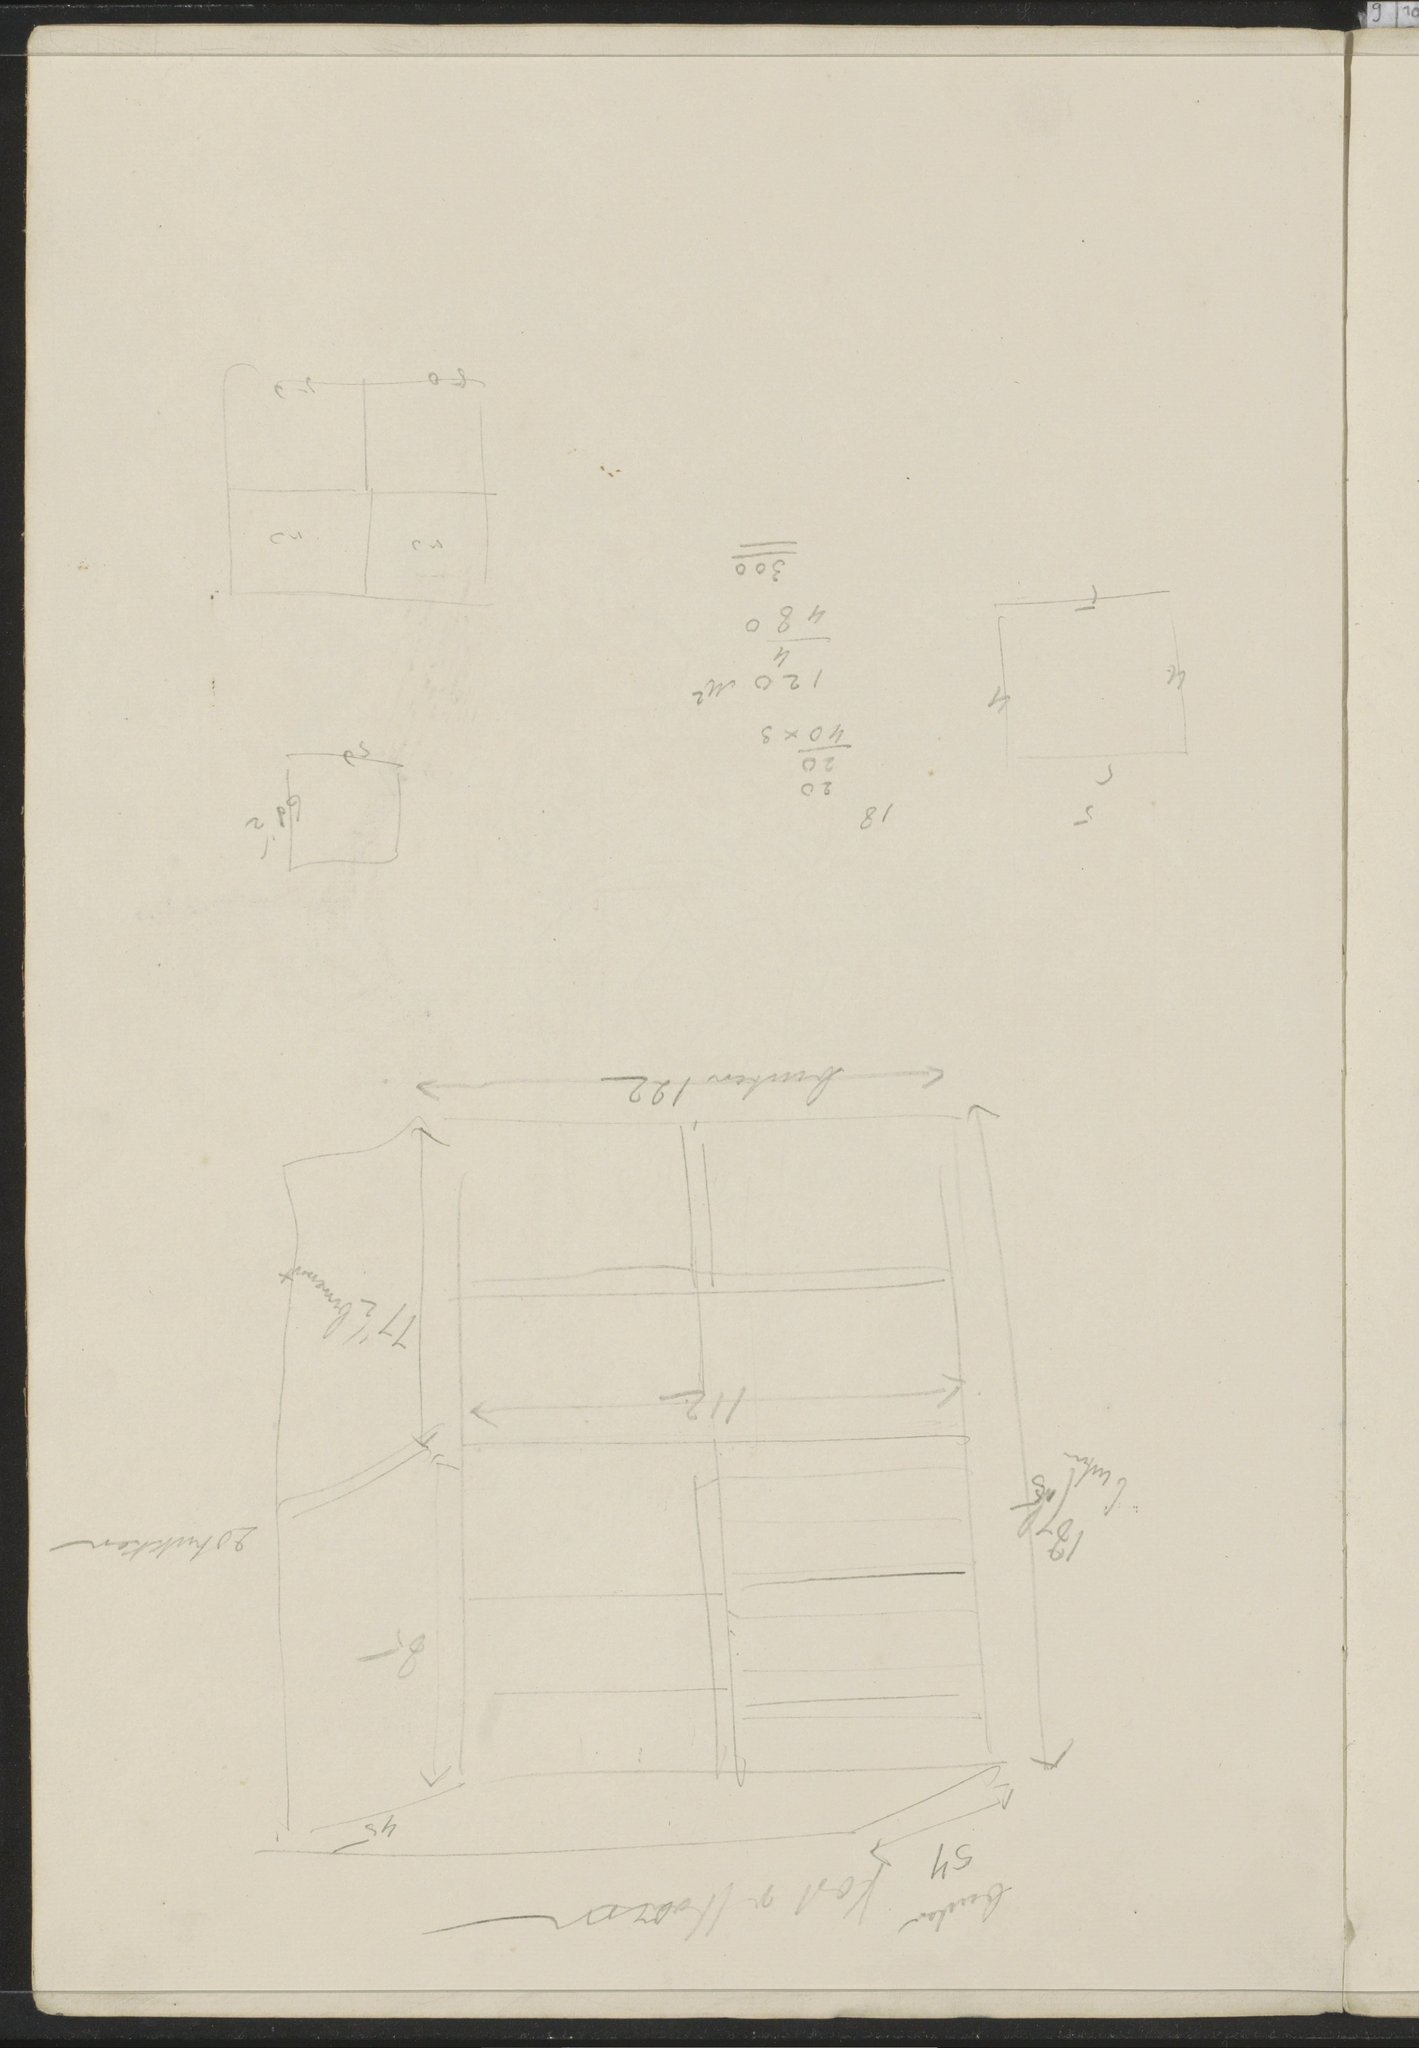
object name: sketchbook leaf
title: Ontwerp voor een kast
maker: carel adolph lion cachet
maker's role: draughtsman, print maker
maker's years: 1864-1945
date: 1903-1904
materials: paper, pencil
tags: furniture for storage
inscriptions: annotation: ‘berken/ kast v Hoorn/ [...]’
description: Blad 4 verso uit een schetsboek met 17 bladen.